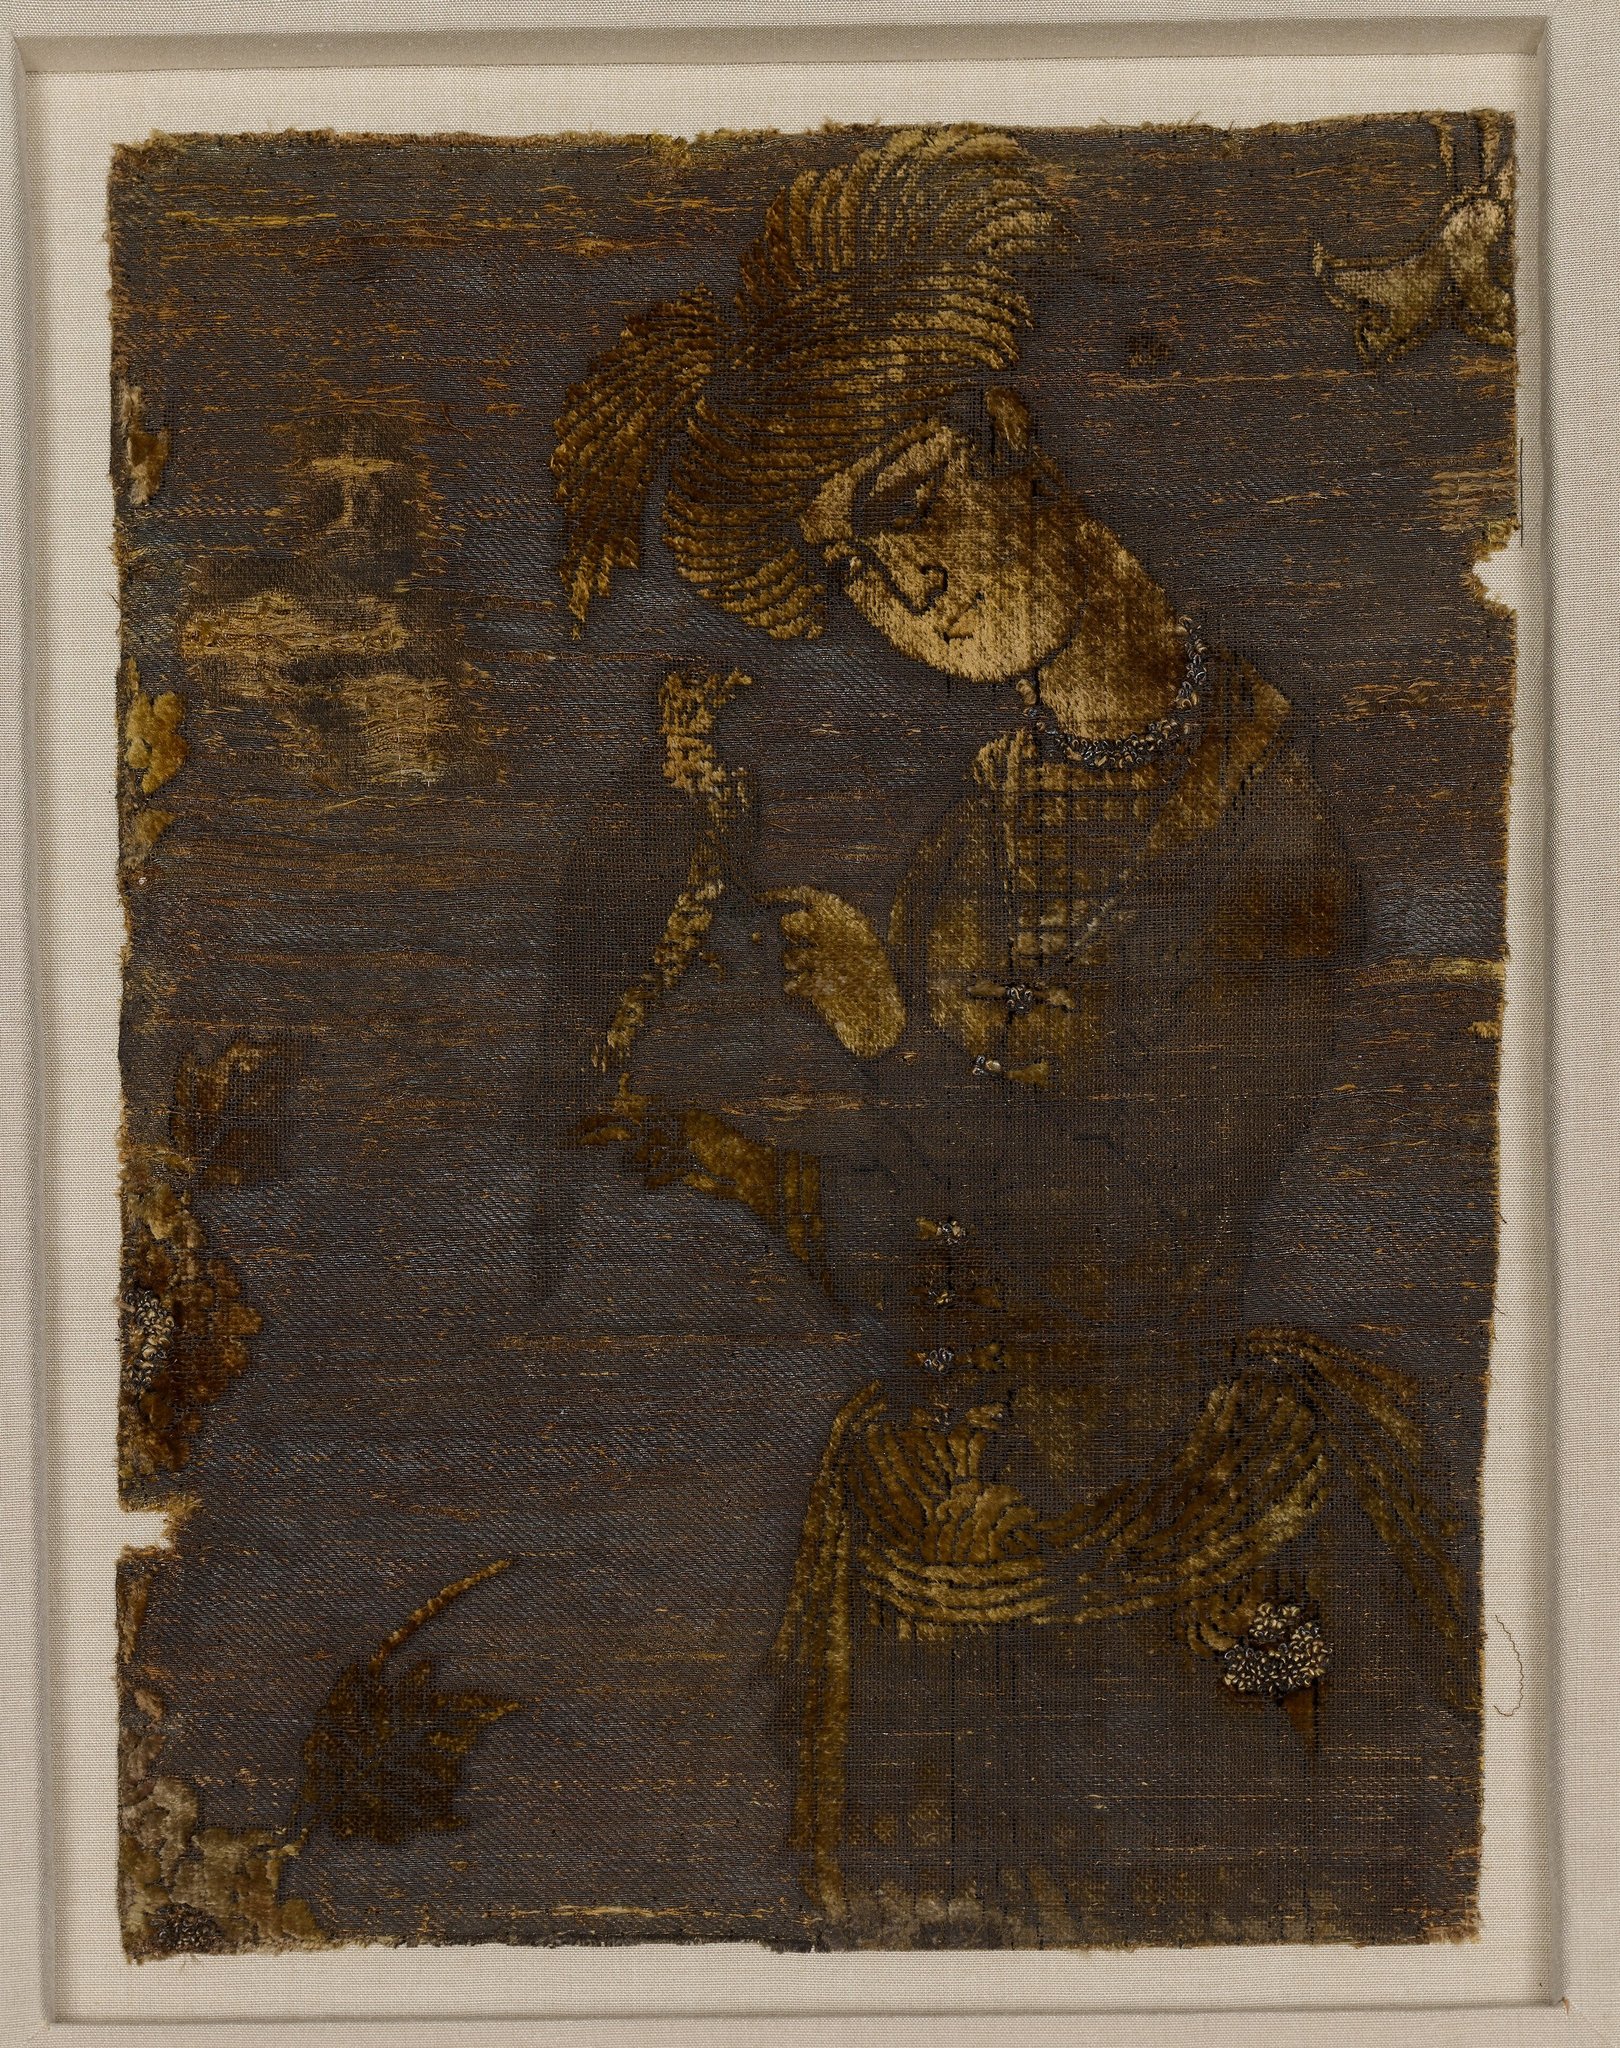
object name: textile fragment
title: A Young Man Attending to a Falcon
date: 1601-1633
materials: metal thread, silk, velvet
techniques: cutting, voiding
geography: iran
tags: falcons,men